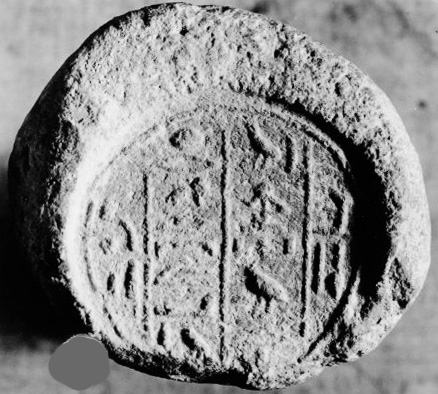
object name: cone, circular impression, turo, chief, medjay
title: Funerary Cone of the Chief of the Medjay Turo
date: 1550-1295 BCE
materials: pottery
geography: egypt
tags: hieroglyphs